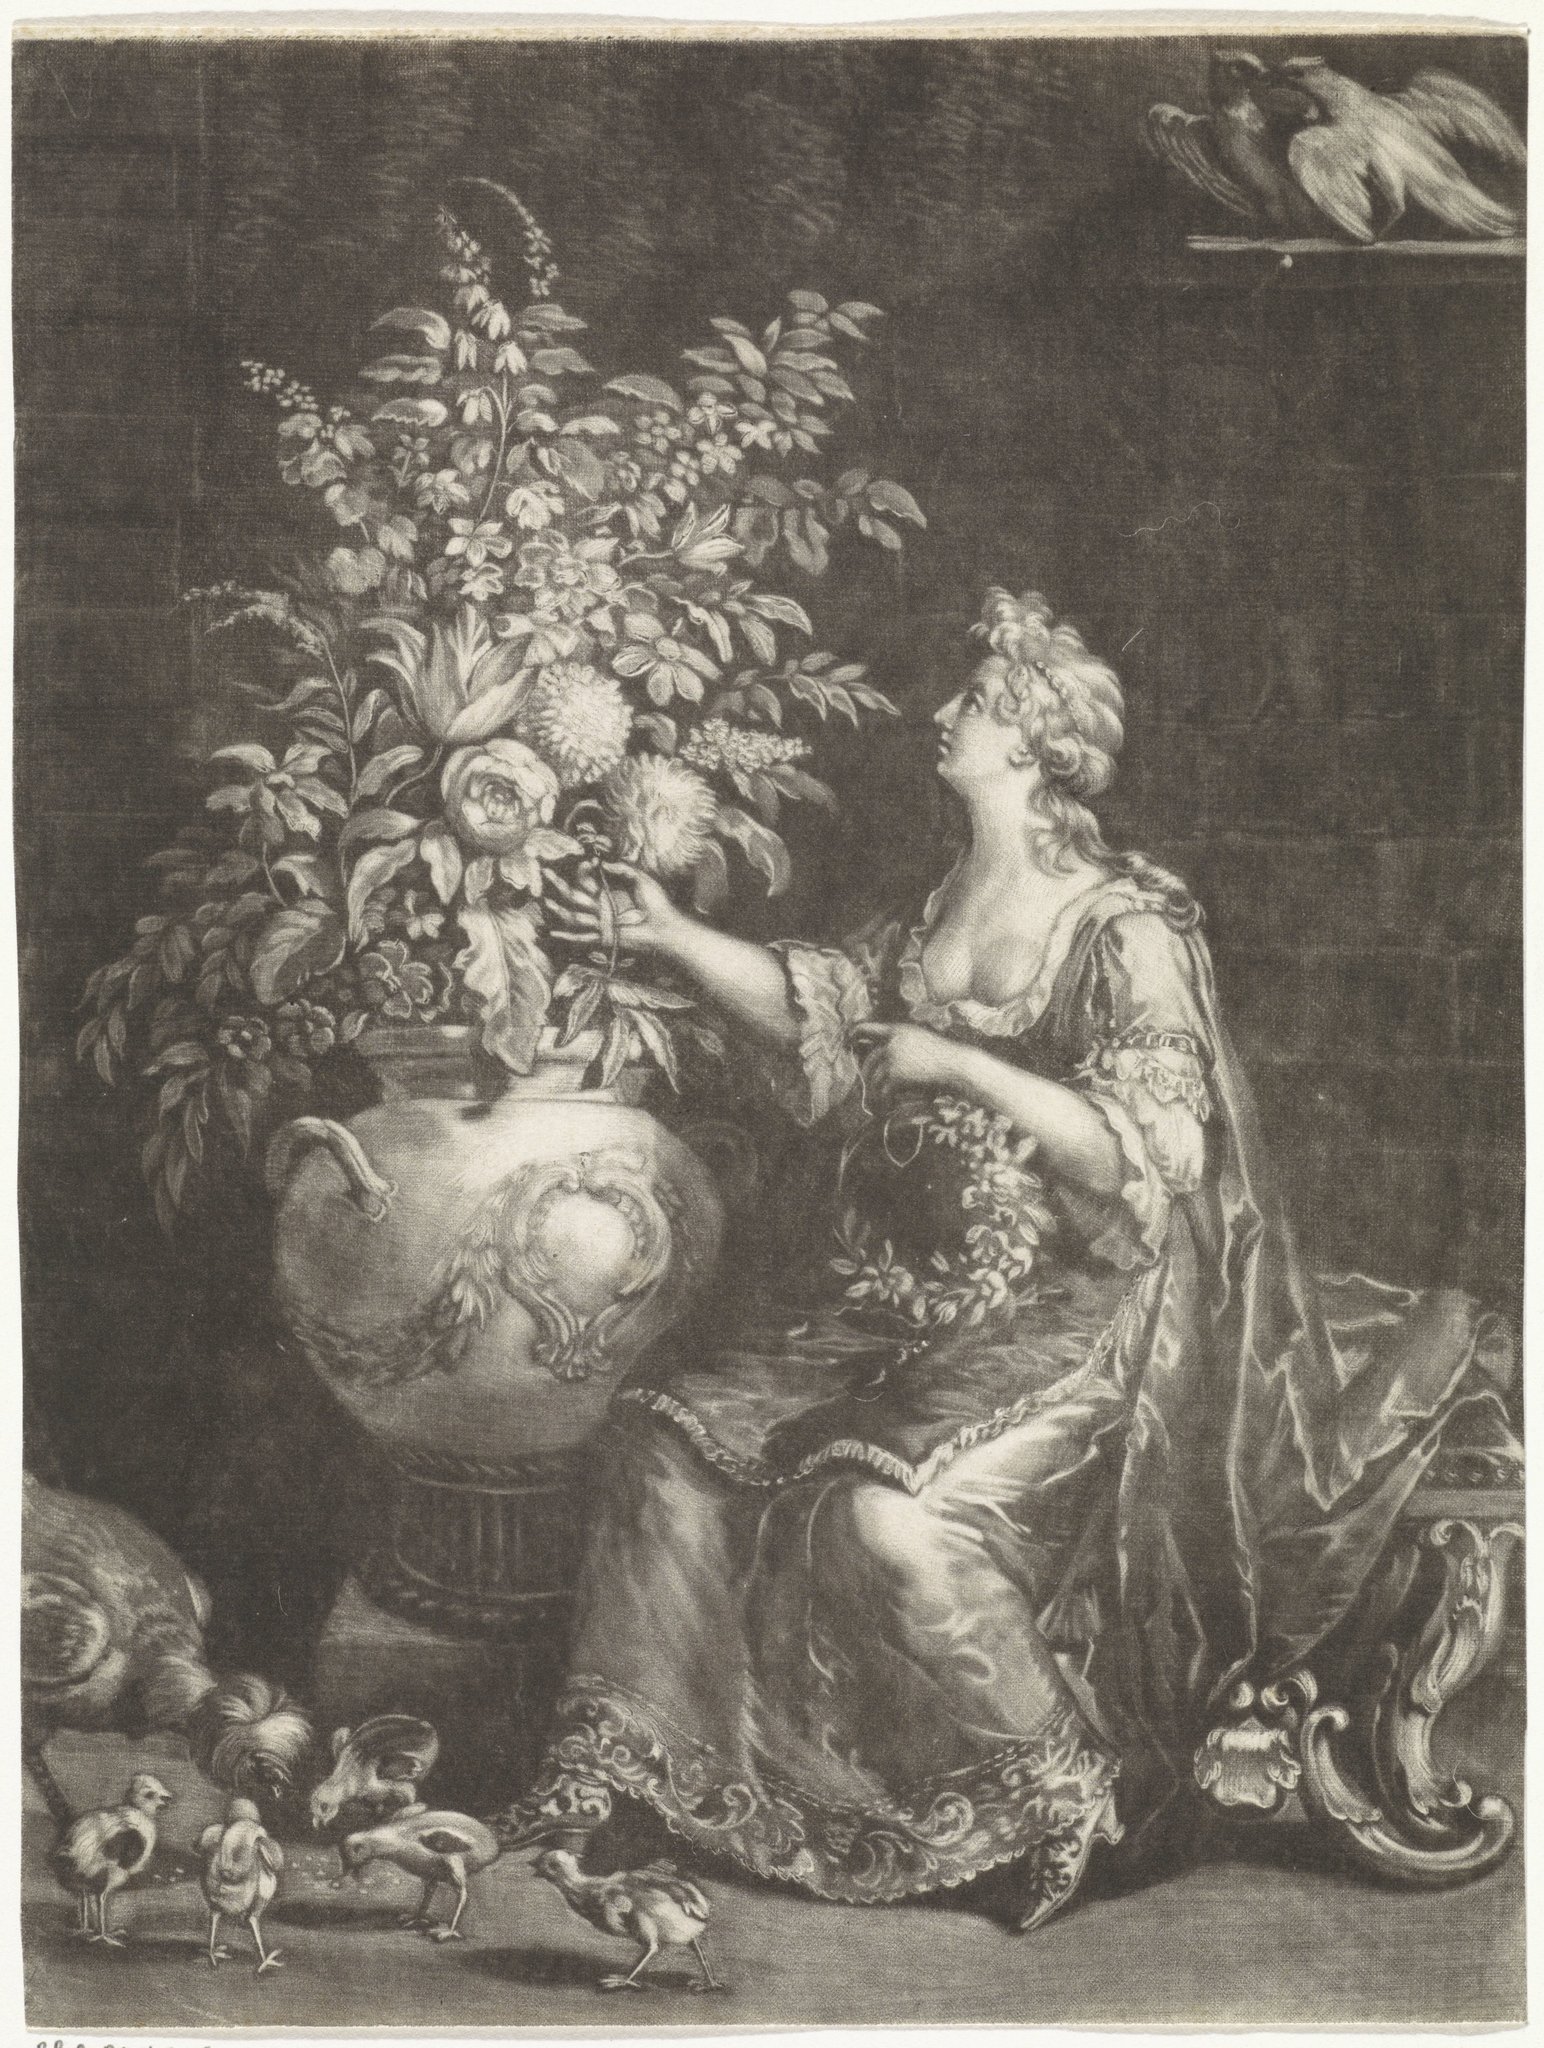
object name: print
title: Lente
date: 1670-1700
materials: paper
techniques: mezzotint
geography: netherlands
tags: cut flowers; nosegay, bunch of flowers, spring, 'ver'; 'primavera' (ripa), doves, pigeons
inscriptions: collector's mark: Lugt 2228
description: Allegorische voorstelling van de lente. Een jonge vrouw vlecht een lentekrans; ze haalt de daarvoor benodigde bloemen uit de grote vaas naast haar. Op de voorgrond pikken een hen en haar kuikens graantjes en op een plankje aan de muur zitten twee vogels te snavelen. De prent maakt deel uit van een serie van vier prenten met de vier seizoenen.